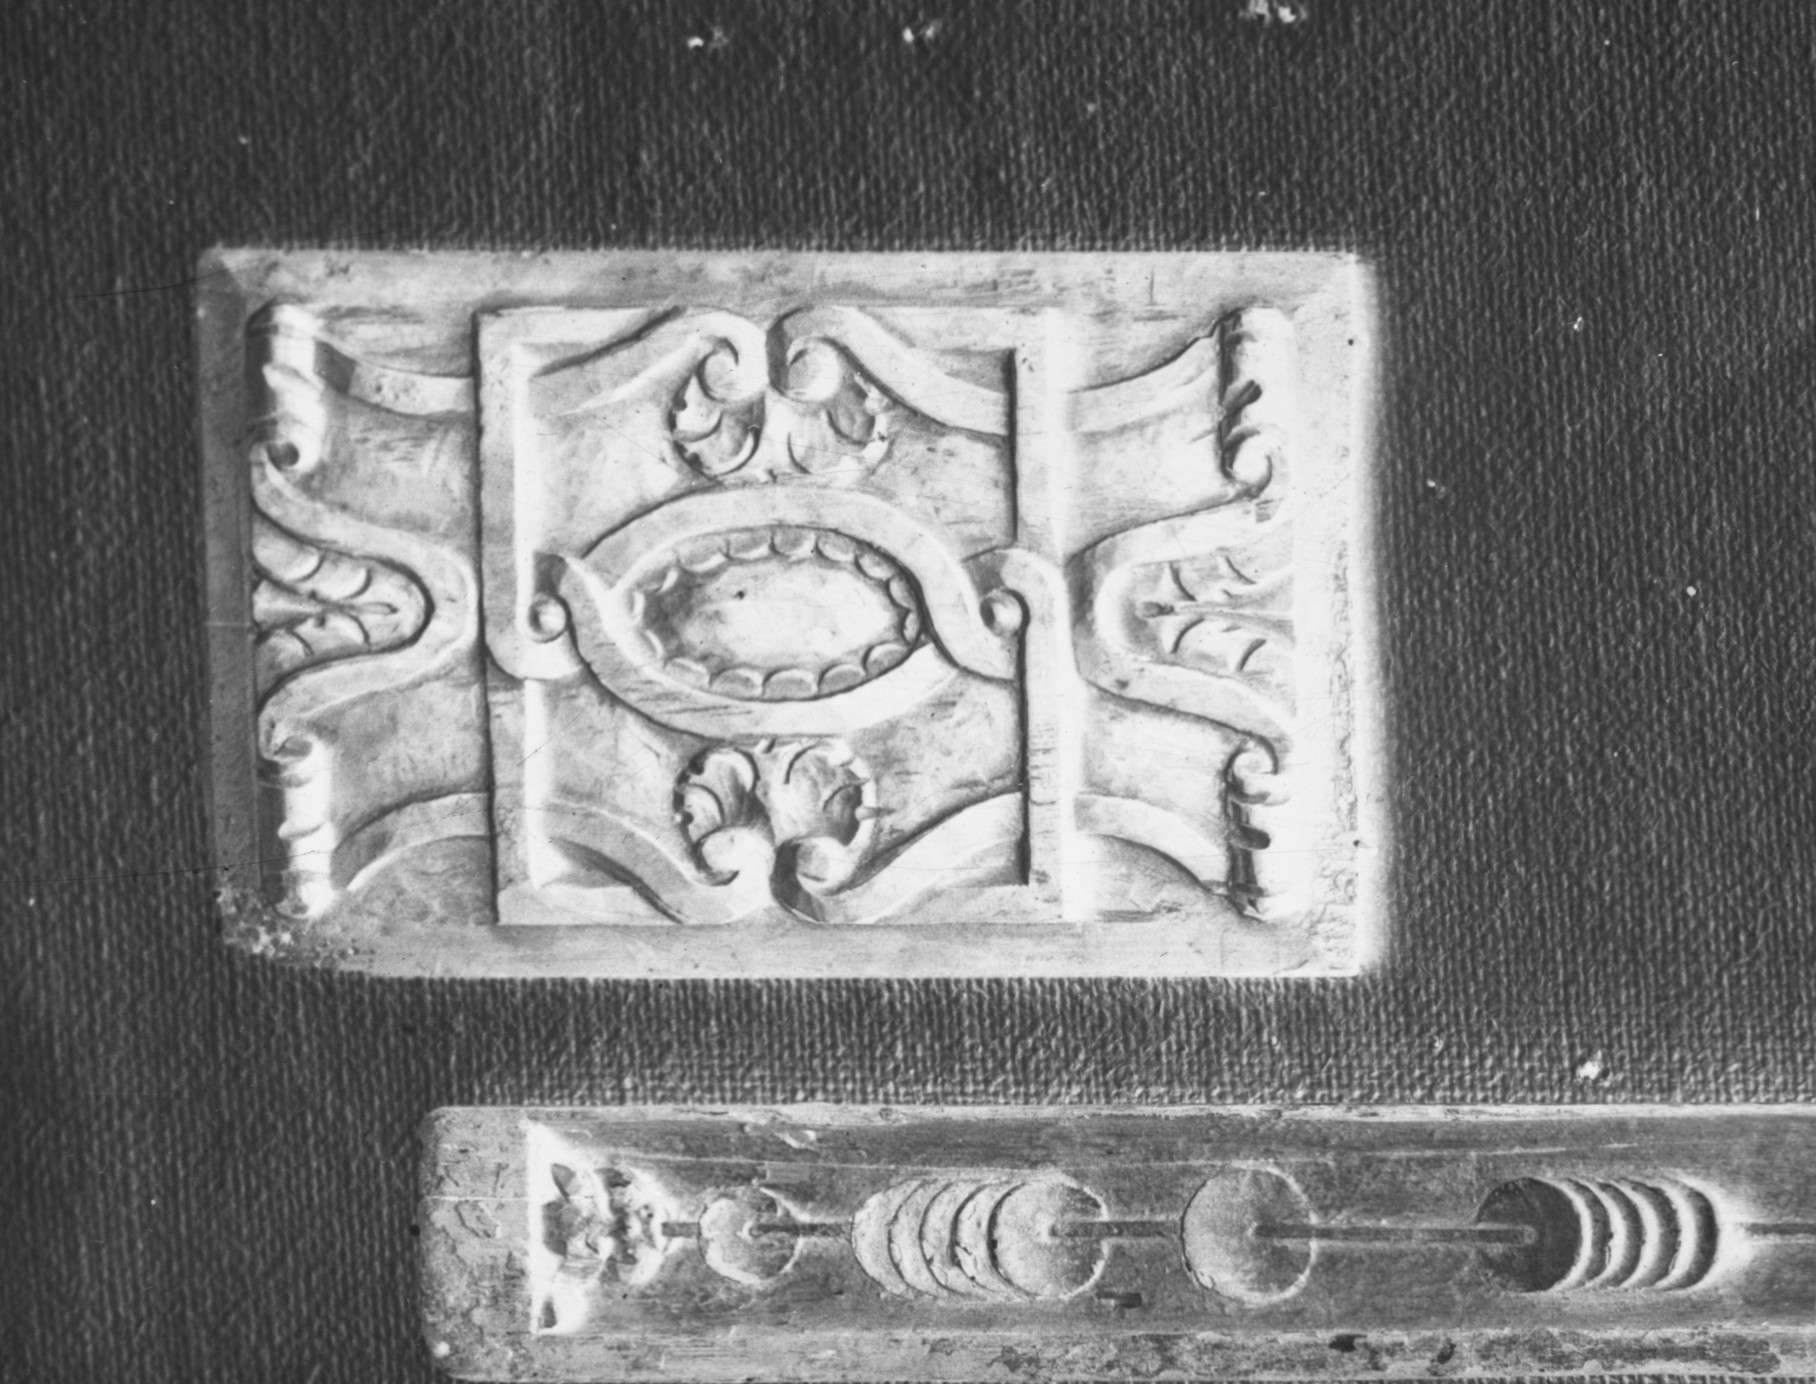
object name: panel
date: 1551-1600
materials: wood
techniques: carving